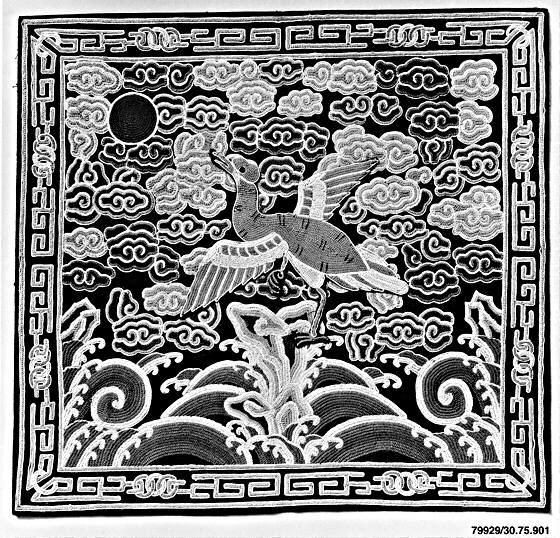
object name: woman's rank badge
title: Woman's Rank Badge with Wild Goose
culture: chinese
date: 1767-1833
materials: silk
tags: geese